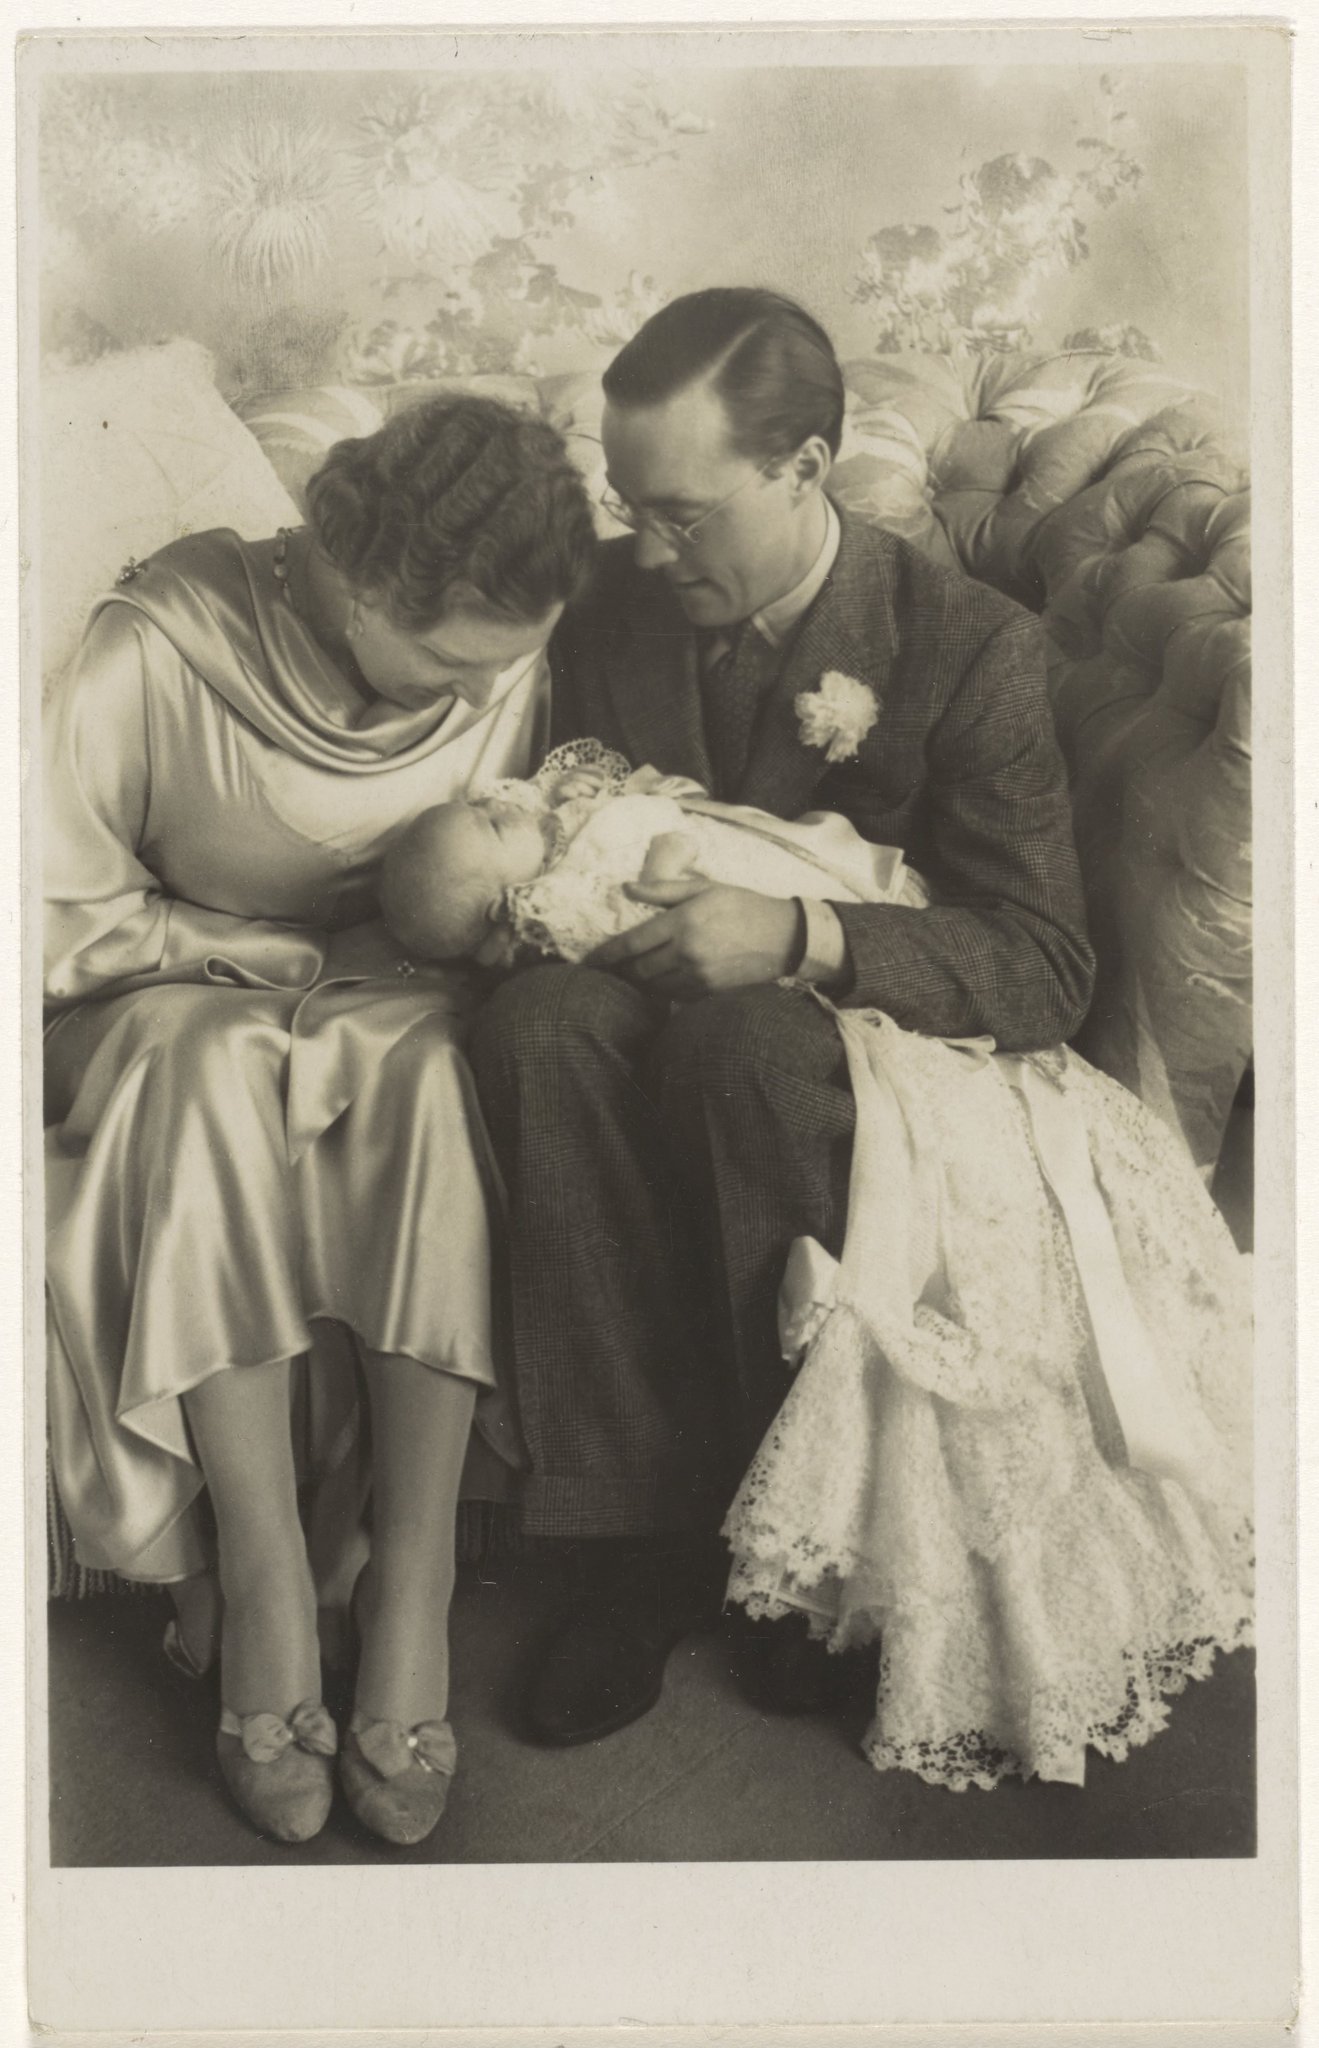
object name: photograph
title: Portret van Juliana, koningin der Nederlanden, Bernhard van Lippe-Biesterfeld en Beatrix, koningin der Nederlanden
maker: Anonymous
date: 1938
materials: photographic support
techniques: photography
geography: rotterdam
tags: bernhard (prins der nederlanden), beatrix (koningin der nederlanden), juliana of the netherlands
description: De hier vermelde titel verwijst naar de hoogst verkregen titel van de geportretteerde, niet per se naar de titel die de geportretteerde op deze voorstelling draagt.